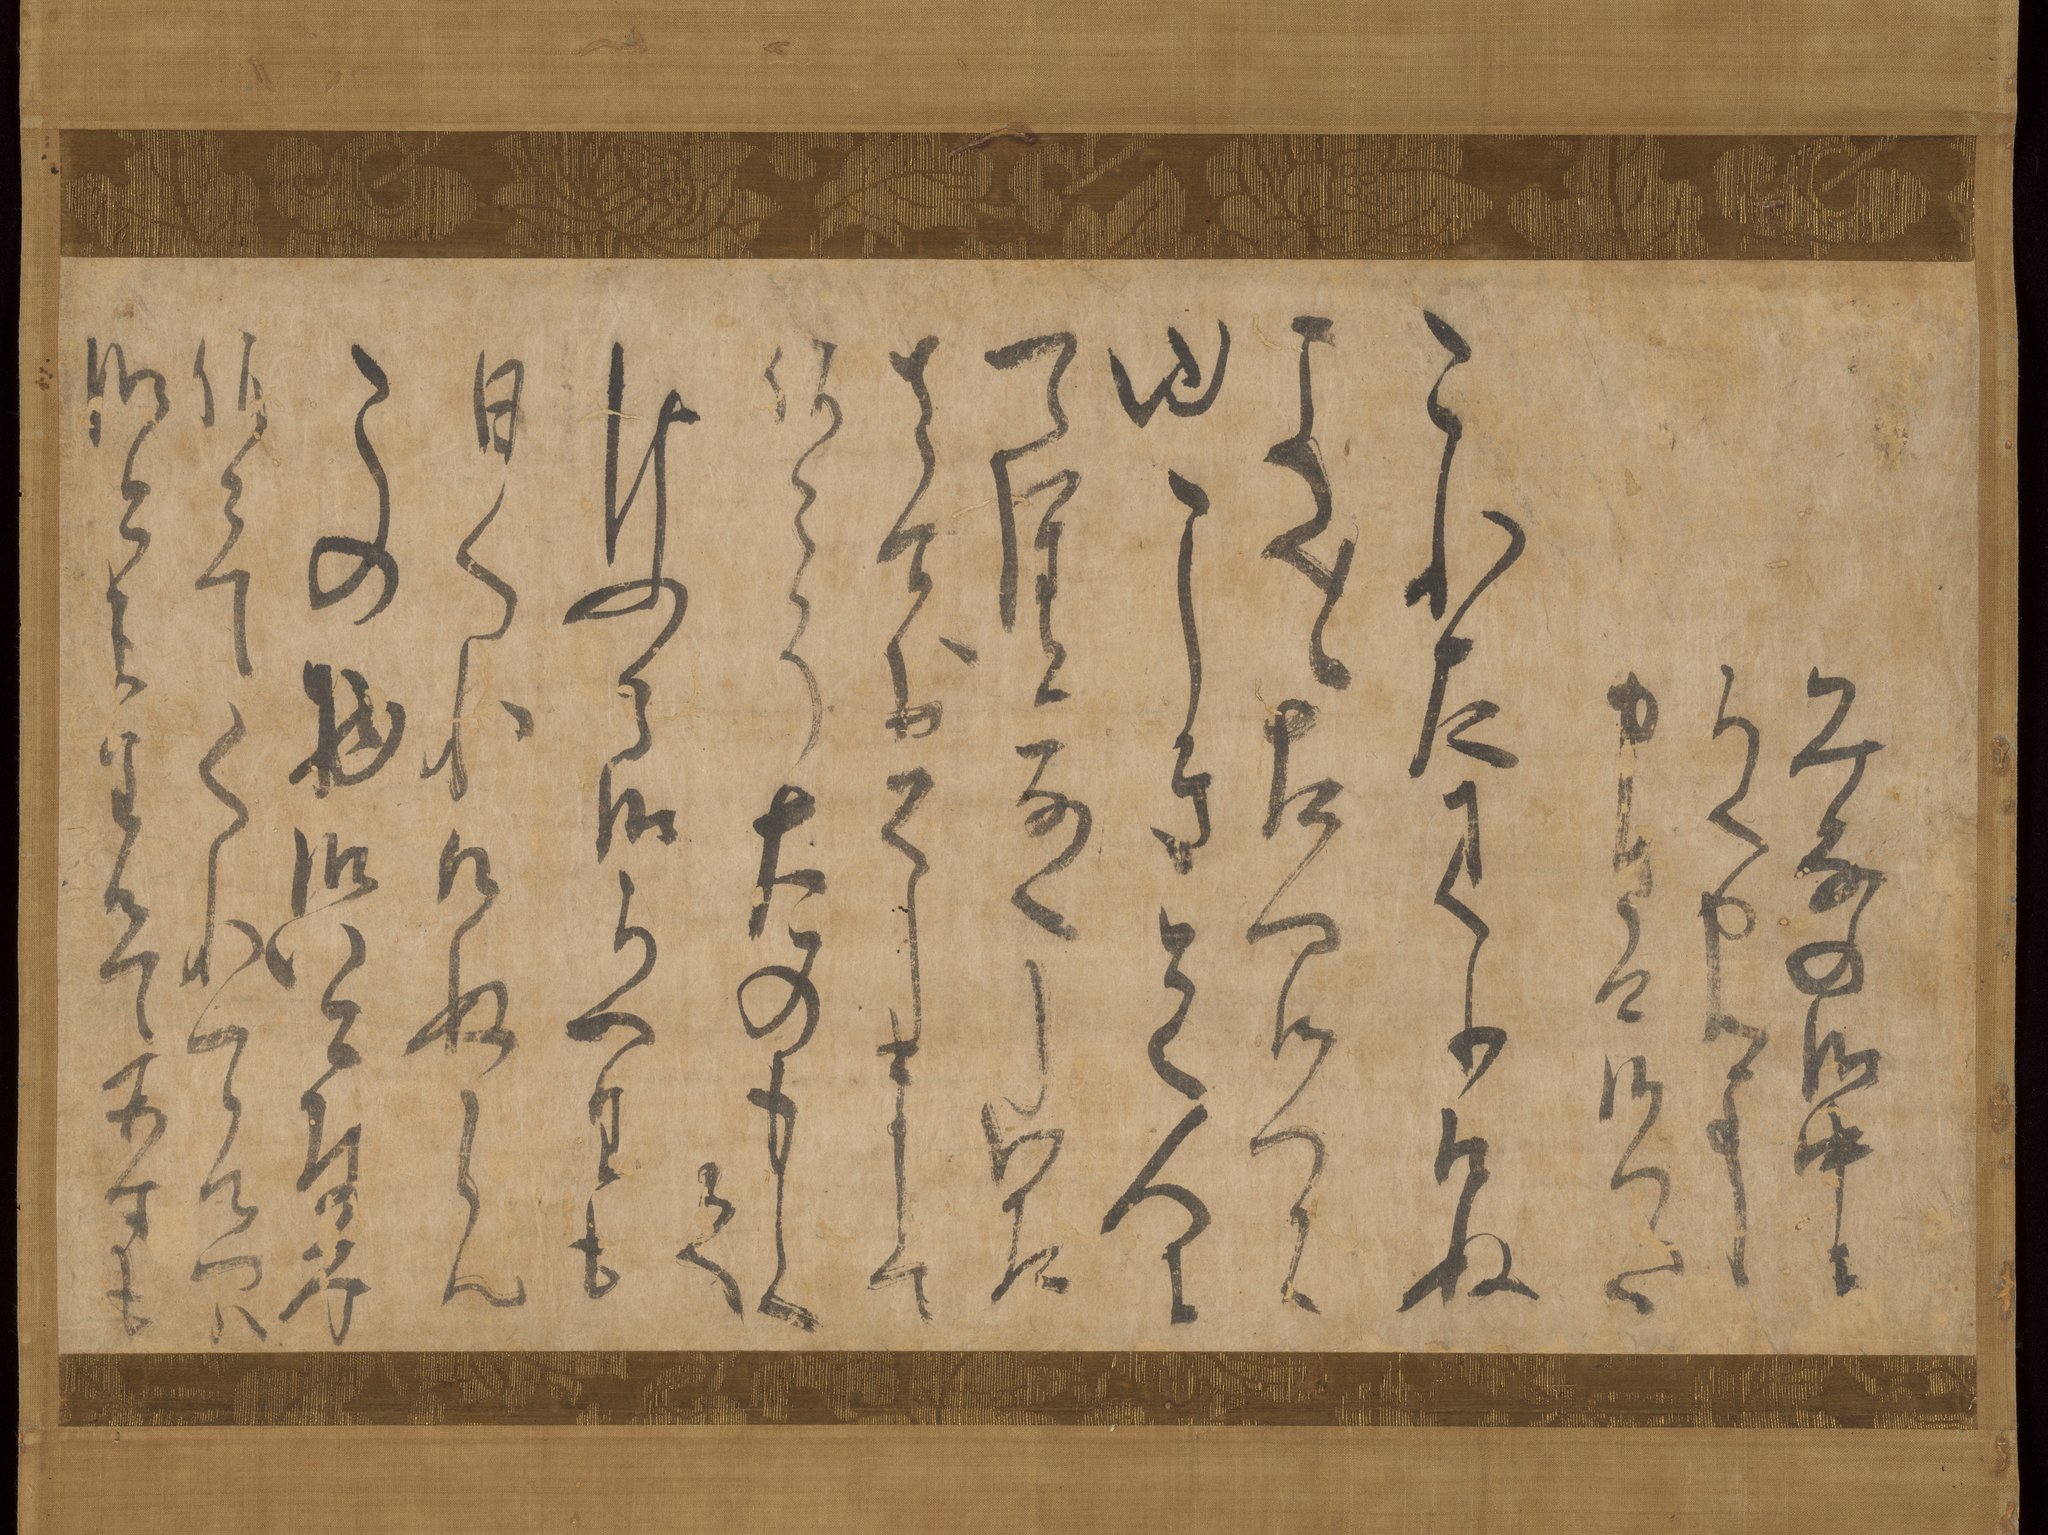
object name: hanging scroll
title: Letter in Kana Characters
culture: japanese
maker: myōe kōben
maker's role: artist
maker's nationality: japanese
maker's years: 1173-1232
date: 1201-1233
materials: ink, paper